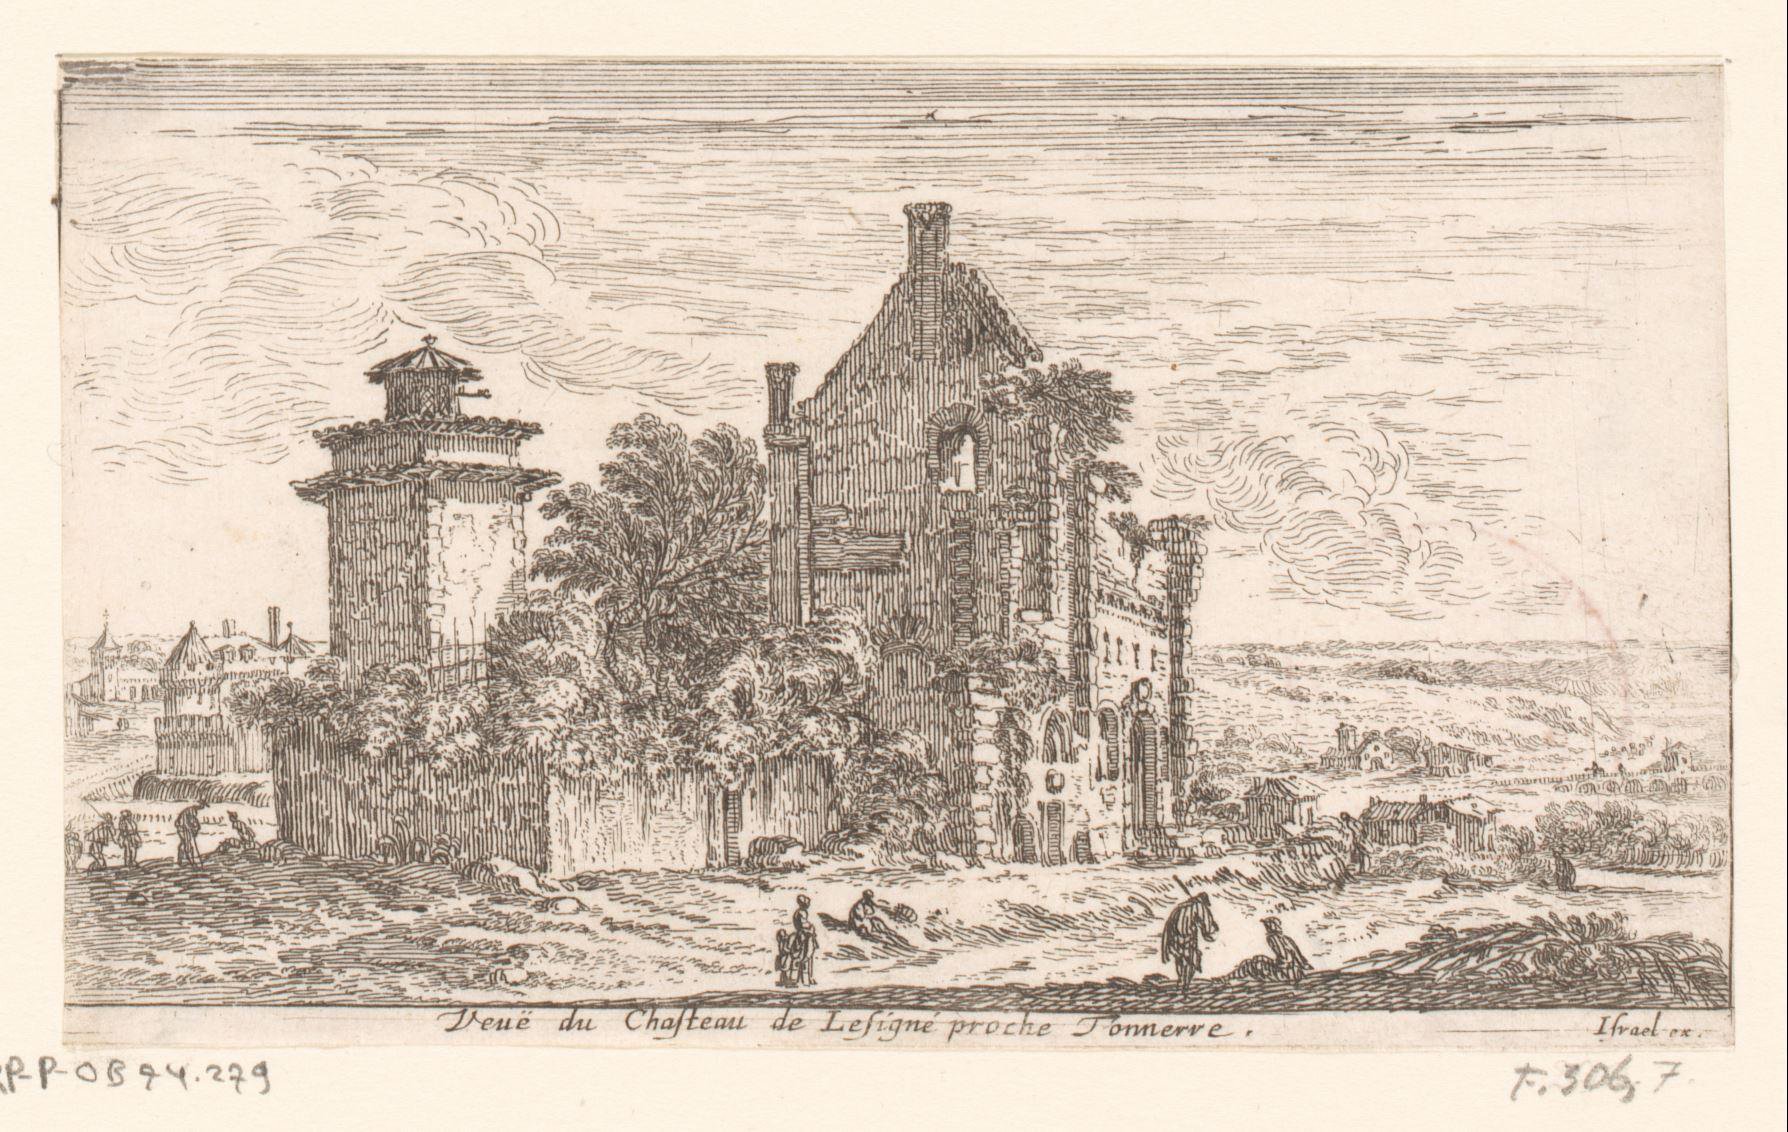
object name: print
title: Veue du Chasteau de Lesigné proche Tonnerre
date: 1631-1661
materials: paper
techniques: etching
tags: city-view, and landscape with man-made constructions, landscape with tower or castle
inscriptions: collector's mark: Lugt 240